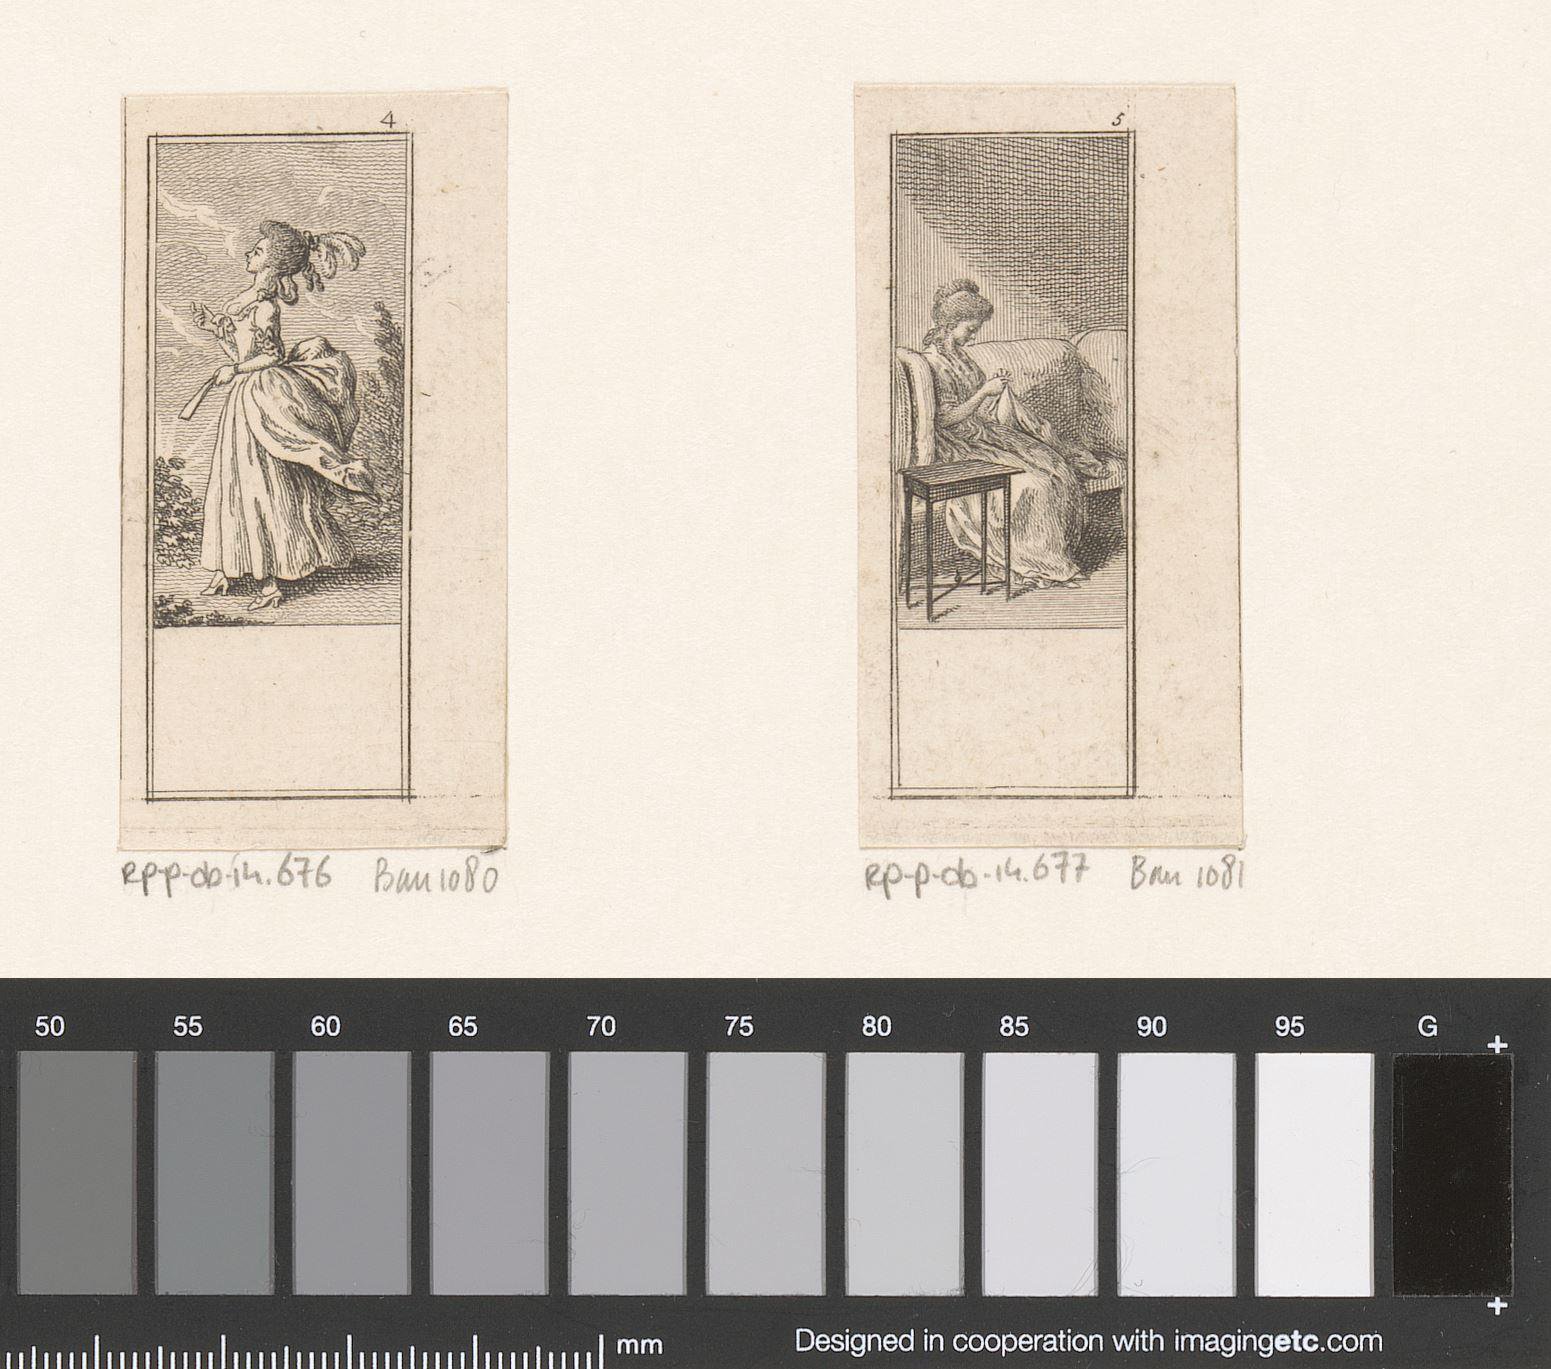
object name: print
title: Brutaalheid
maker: daniel nikolaus chodowiecki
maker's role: draughtsman, print maker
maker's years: 1726-1801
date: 1784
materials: paper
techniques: etching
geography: berlin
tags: good and bad behaviour, moral qualities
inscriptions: collector's mark: Lugt 2228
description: Latere staat gebruikt voor: Kleinen Taschen Calender auf das gemeine Jahr 1785 (...). Berlijn: S.n., 1784.